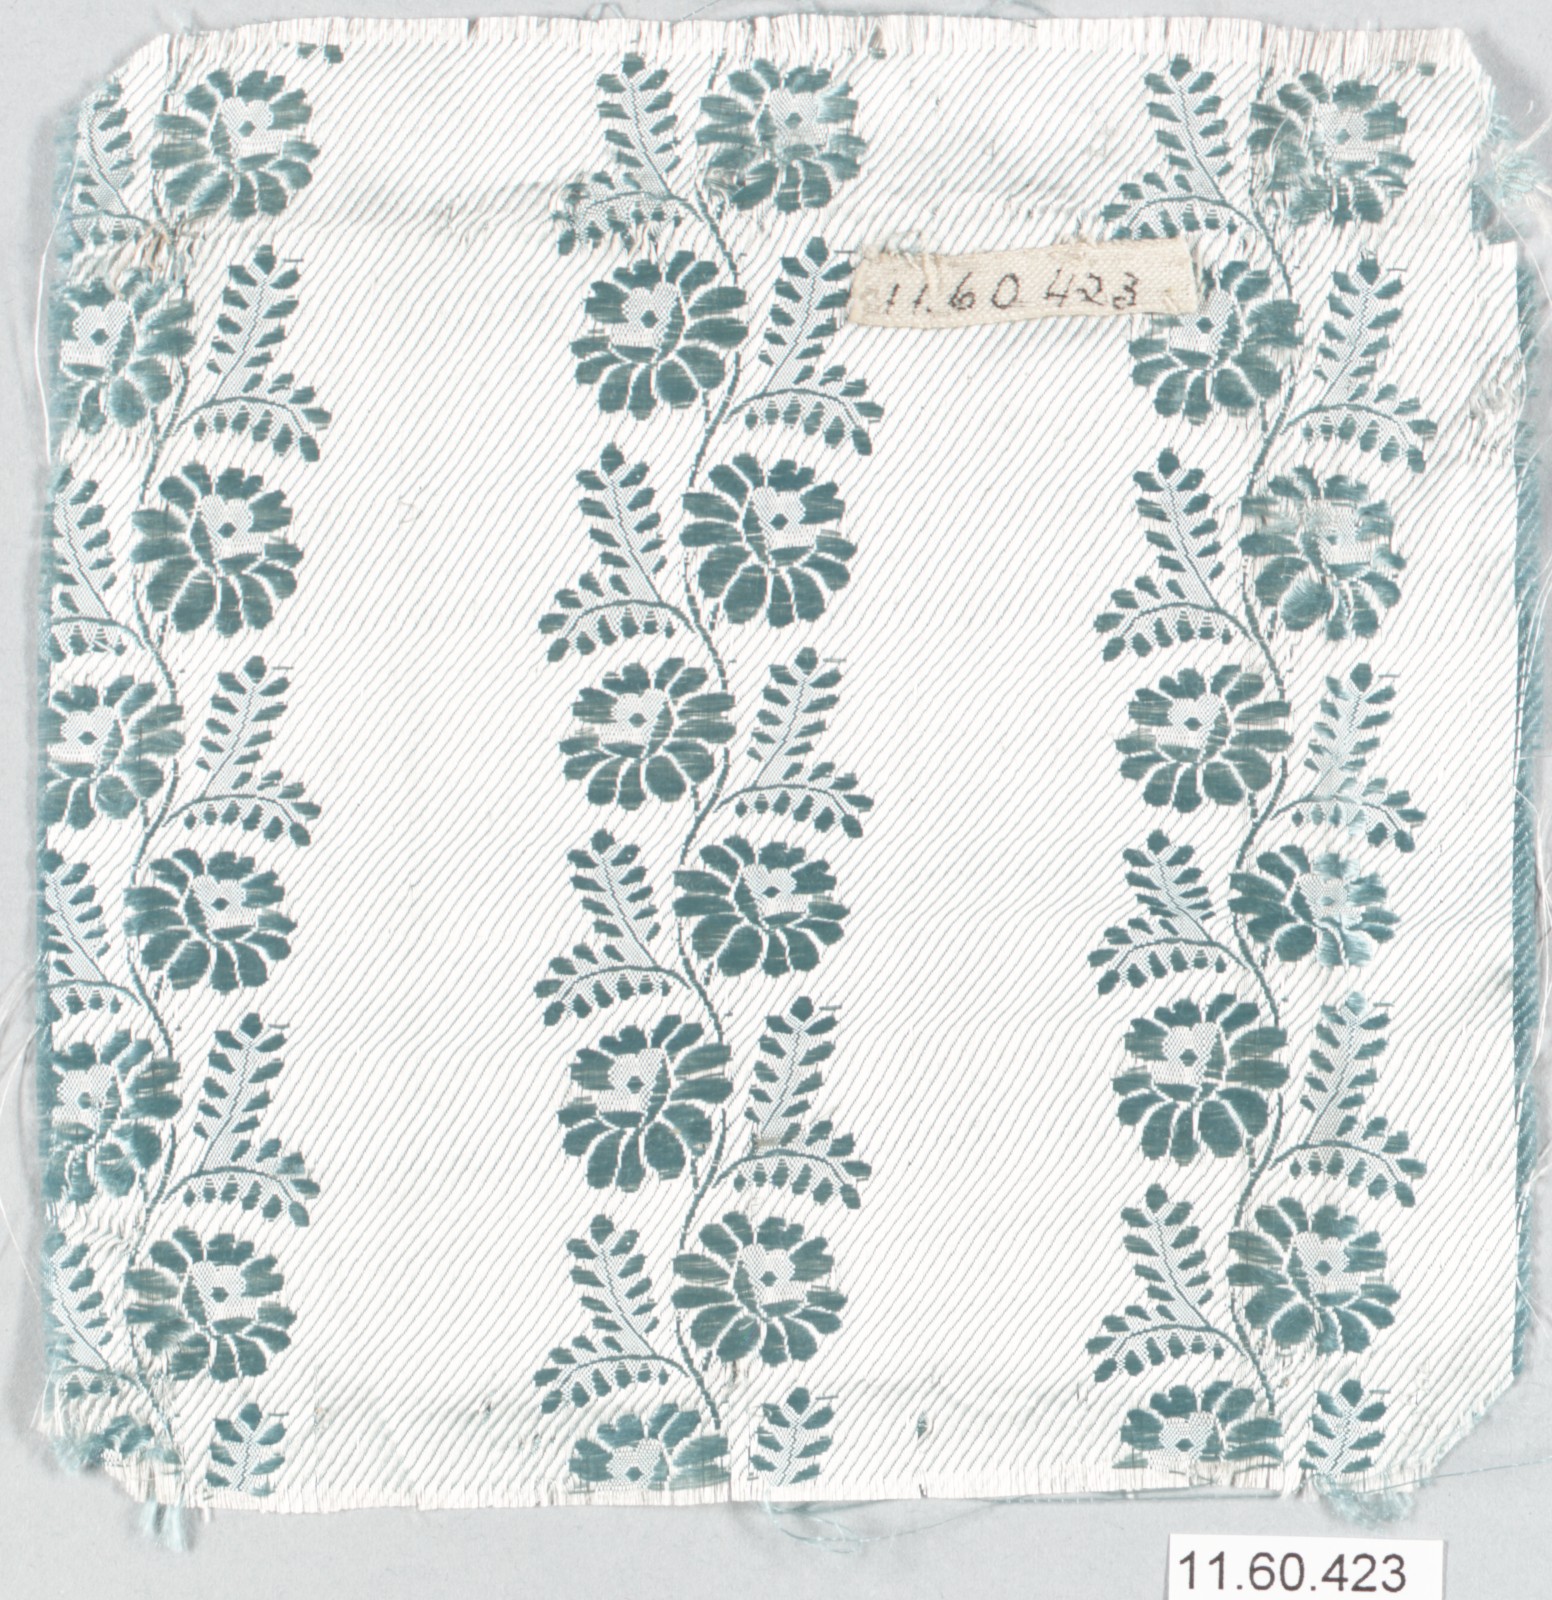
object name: fragment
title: Fragments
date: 1801-1900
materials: silk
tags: flowers,leaves